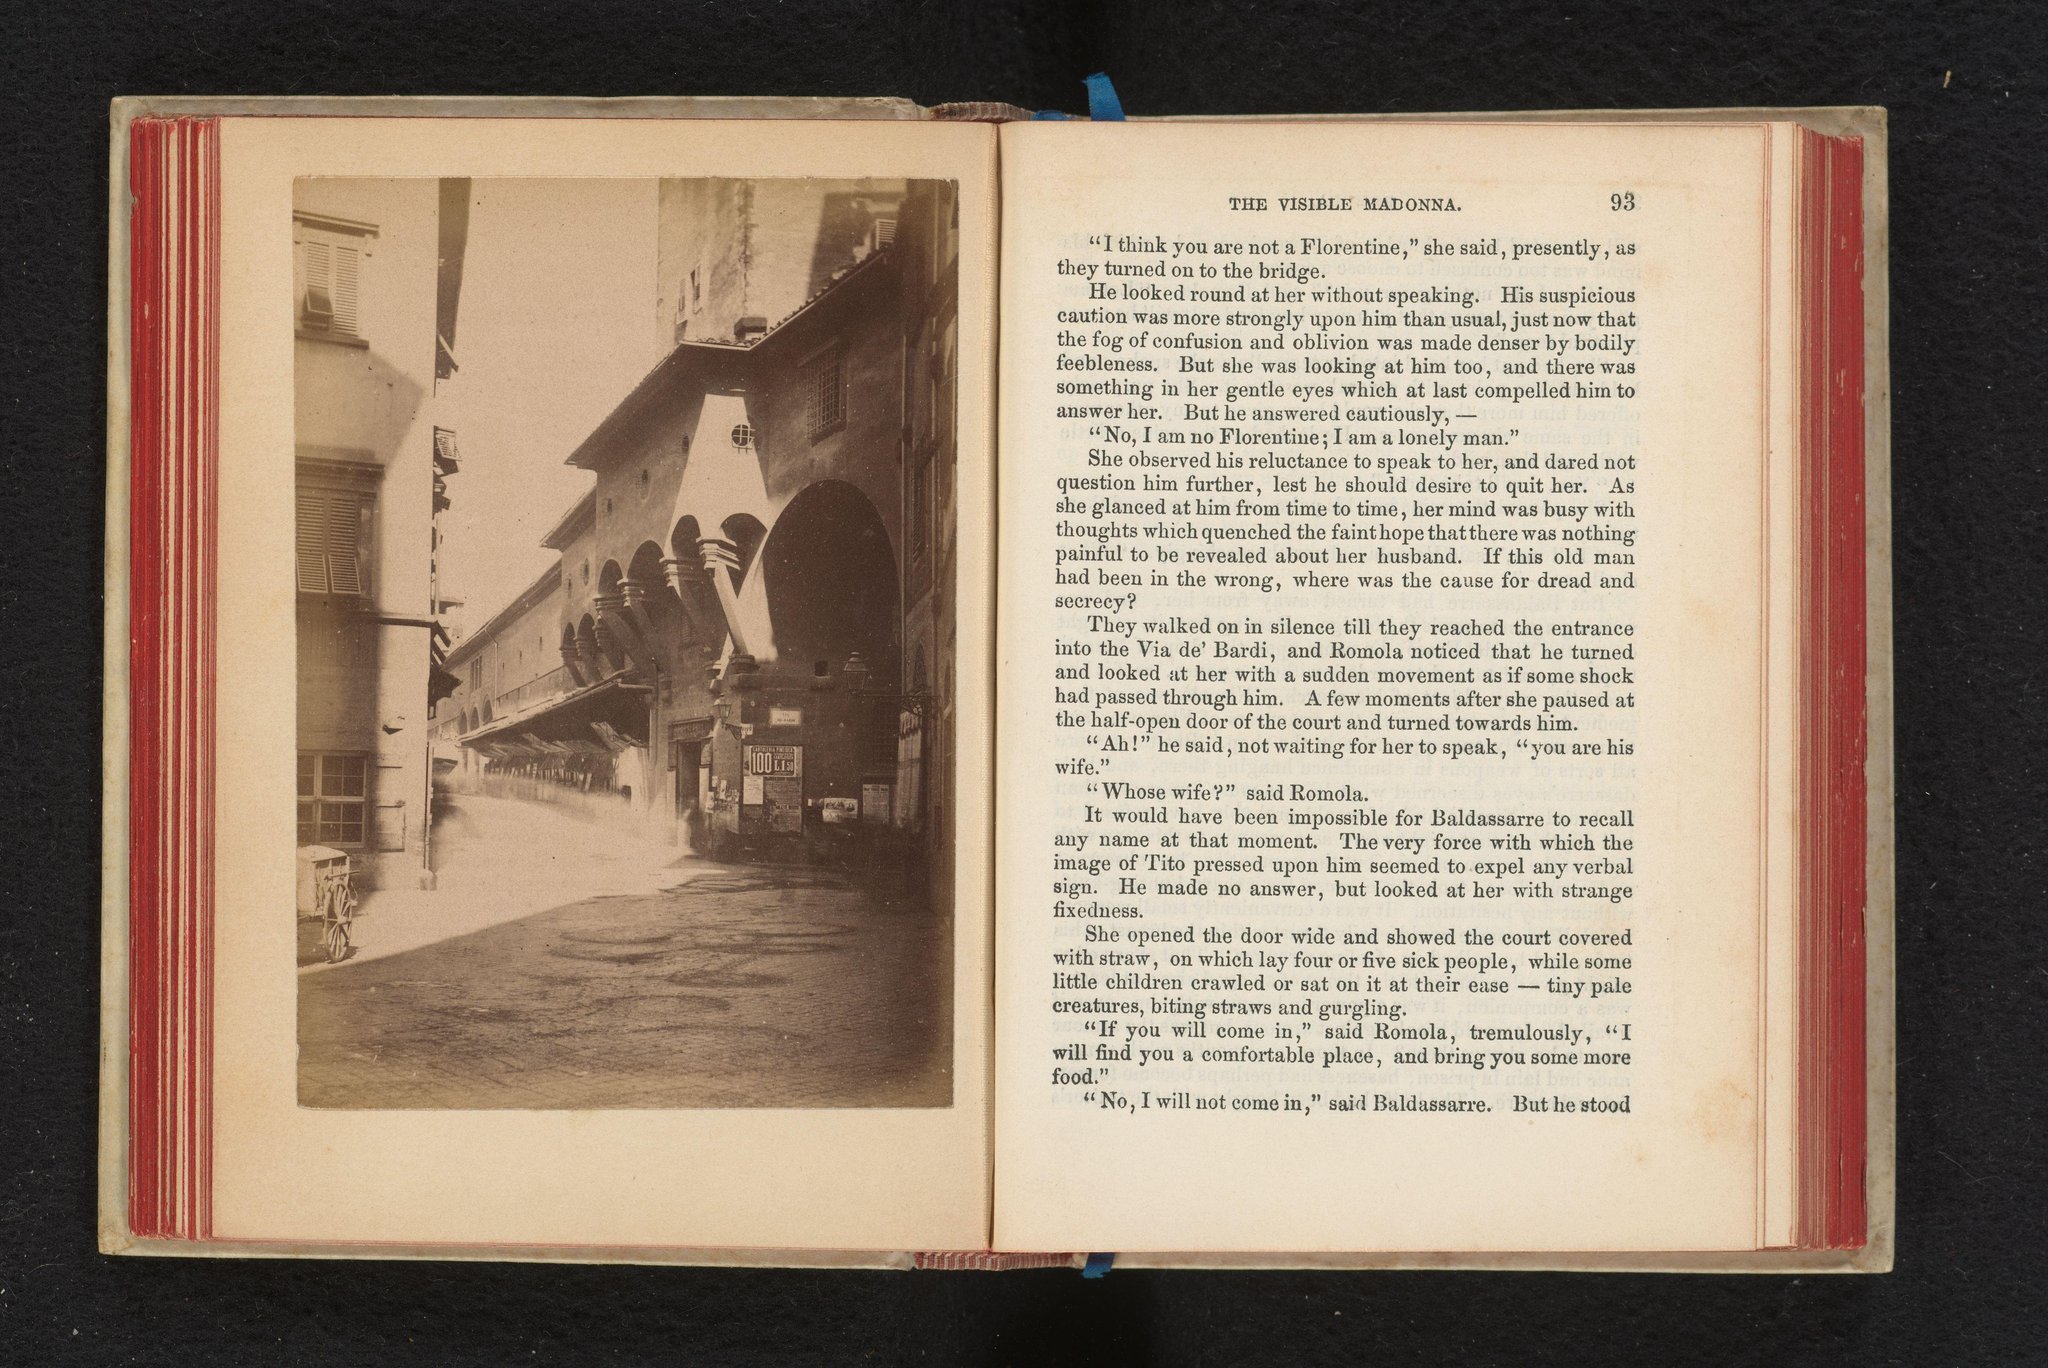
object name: page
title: Toren van de Mannelli bij de Ponte Vecchio, Florence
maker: giacomo brogi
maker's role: fotograaf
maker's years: 1822-1881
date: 1858-1863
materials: paper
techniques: albumen print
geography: florence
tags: street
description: Foto op ongenummerde pagina tegenover pagina 93.